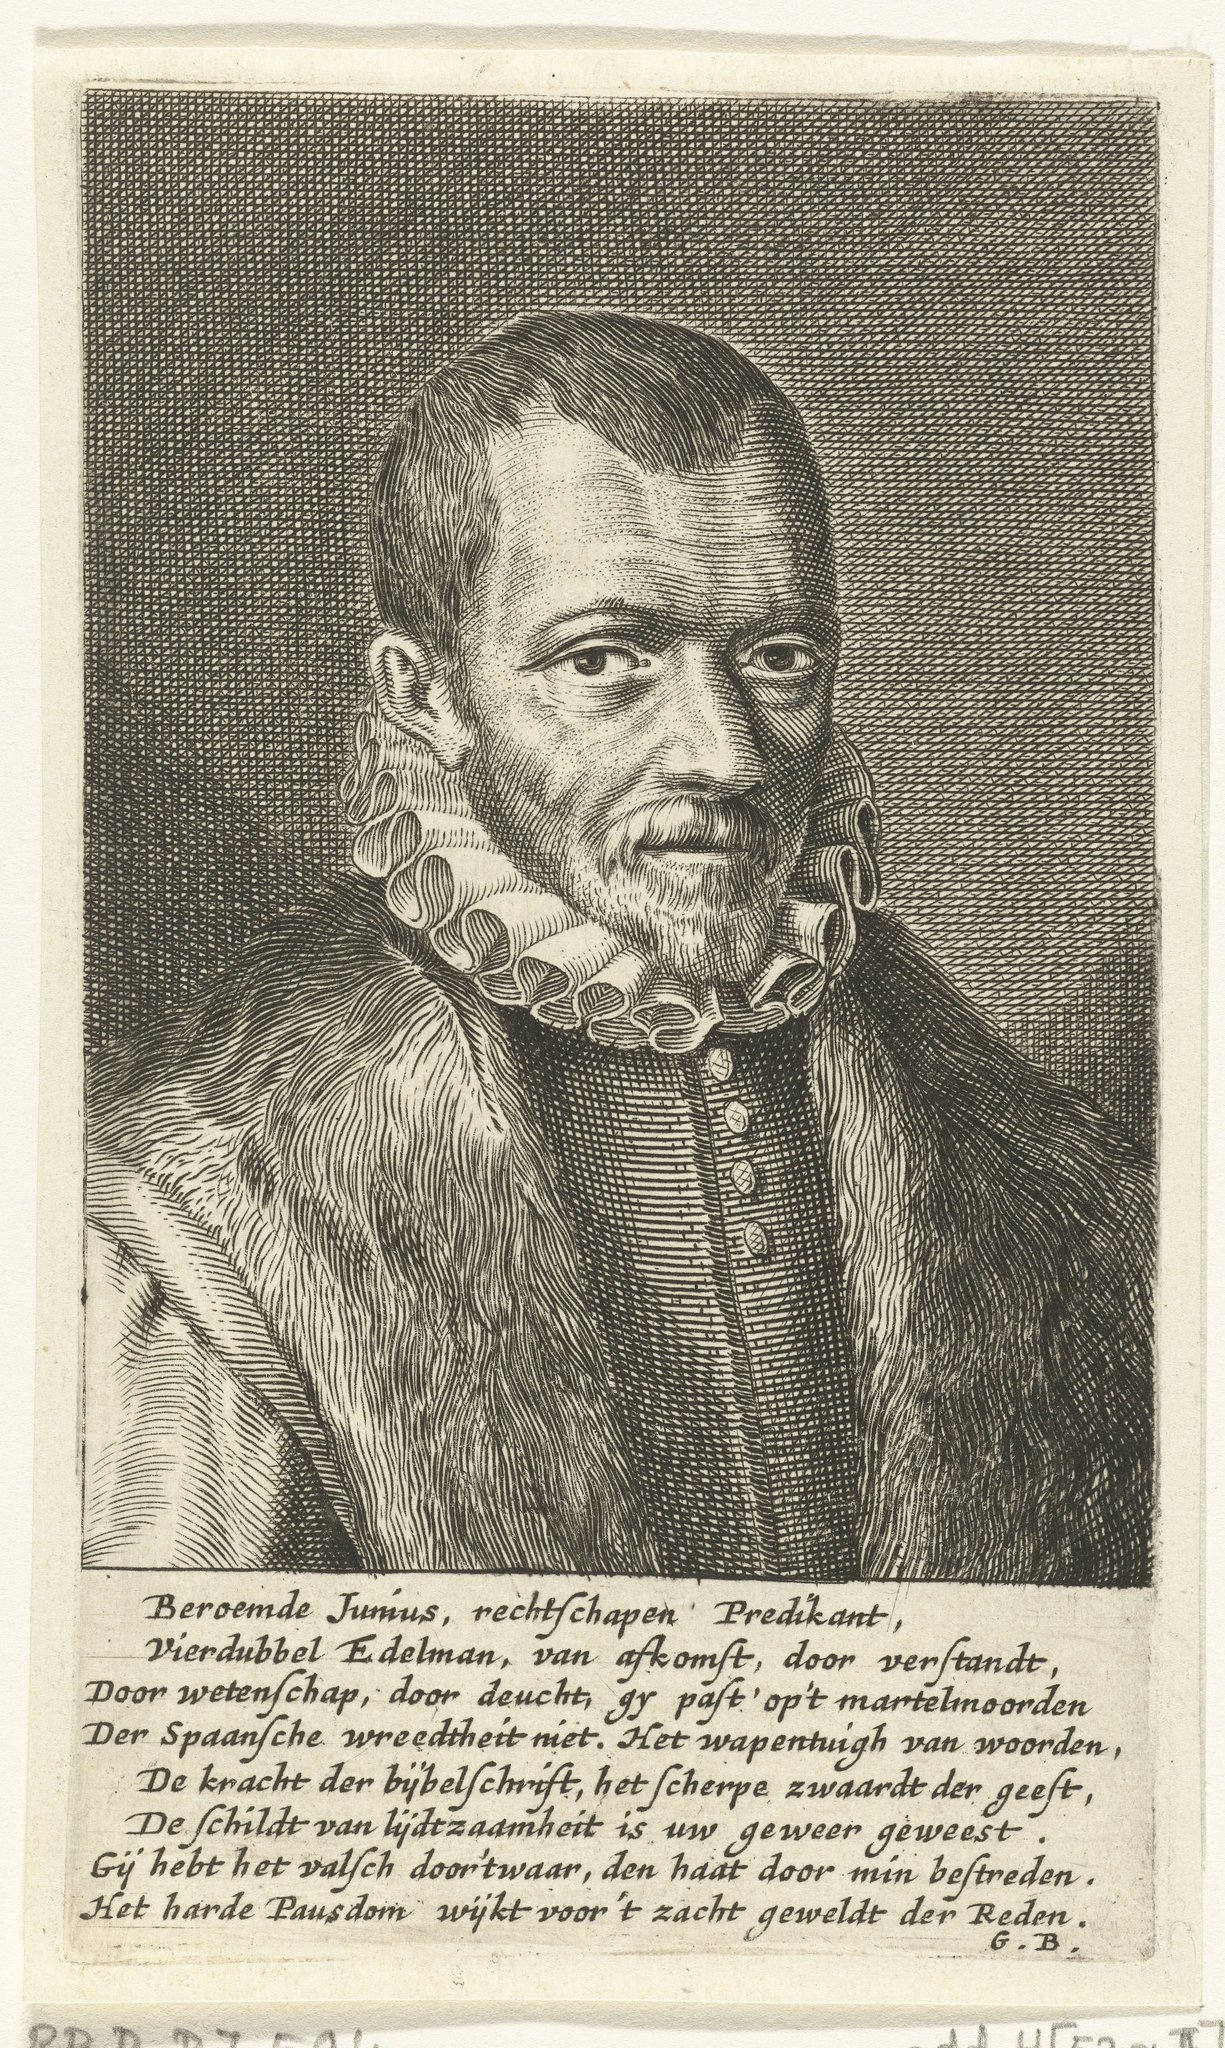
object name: print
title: Portret van Franciscus Junius (I)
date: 1657-1707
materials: paper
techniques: engraving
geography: netherlands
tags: bourges, predikant, theoloog, franciscus junius (i)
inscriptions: collector's mark: Lugt 240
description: Borstbeeld van Franciscus Junius, met een gedicht van acht regels in het Nederlands door Geeraert Brandt.